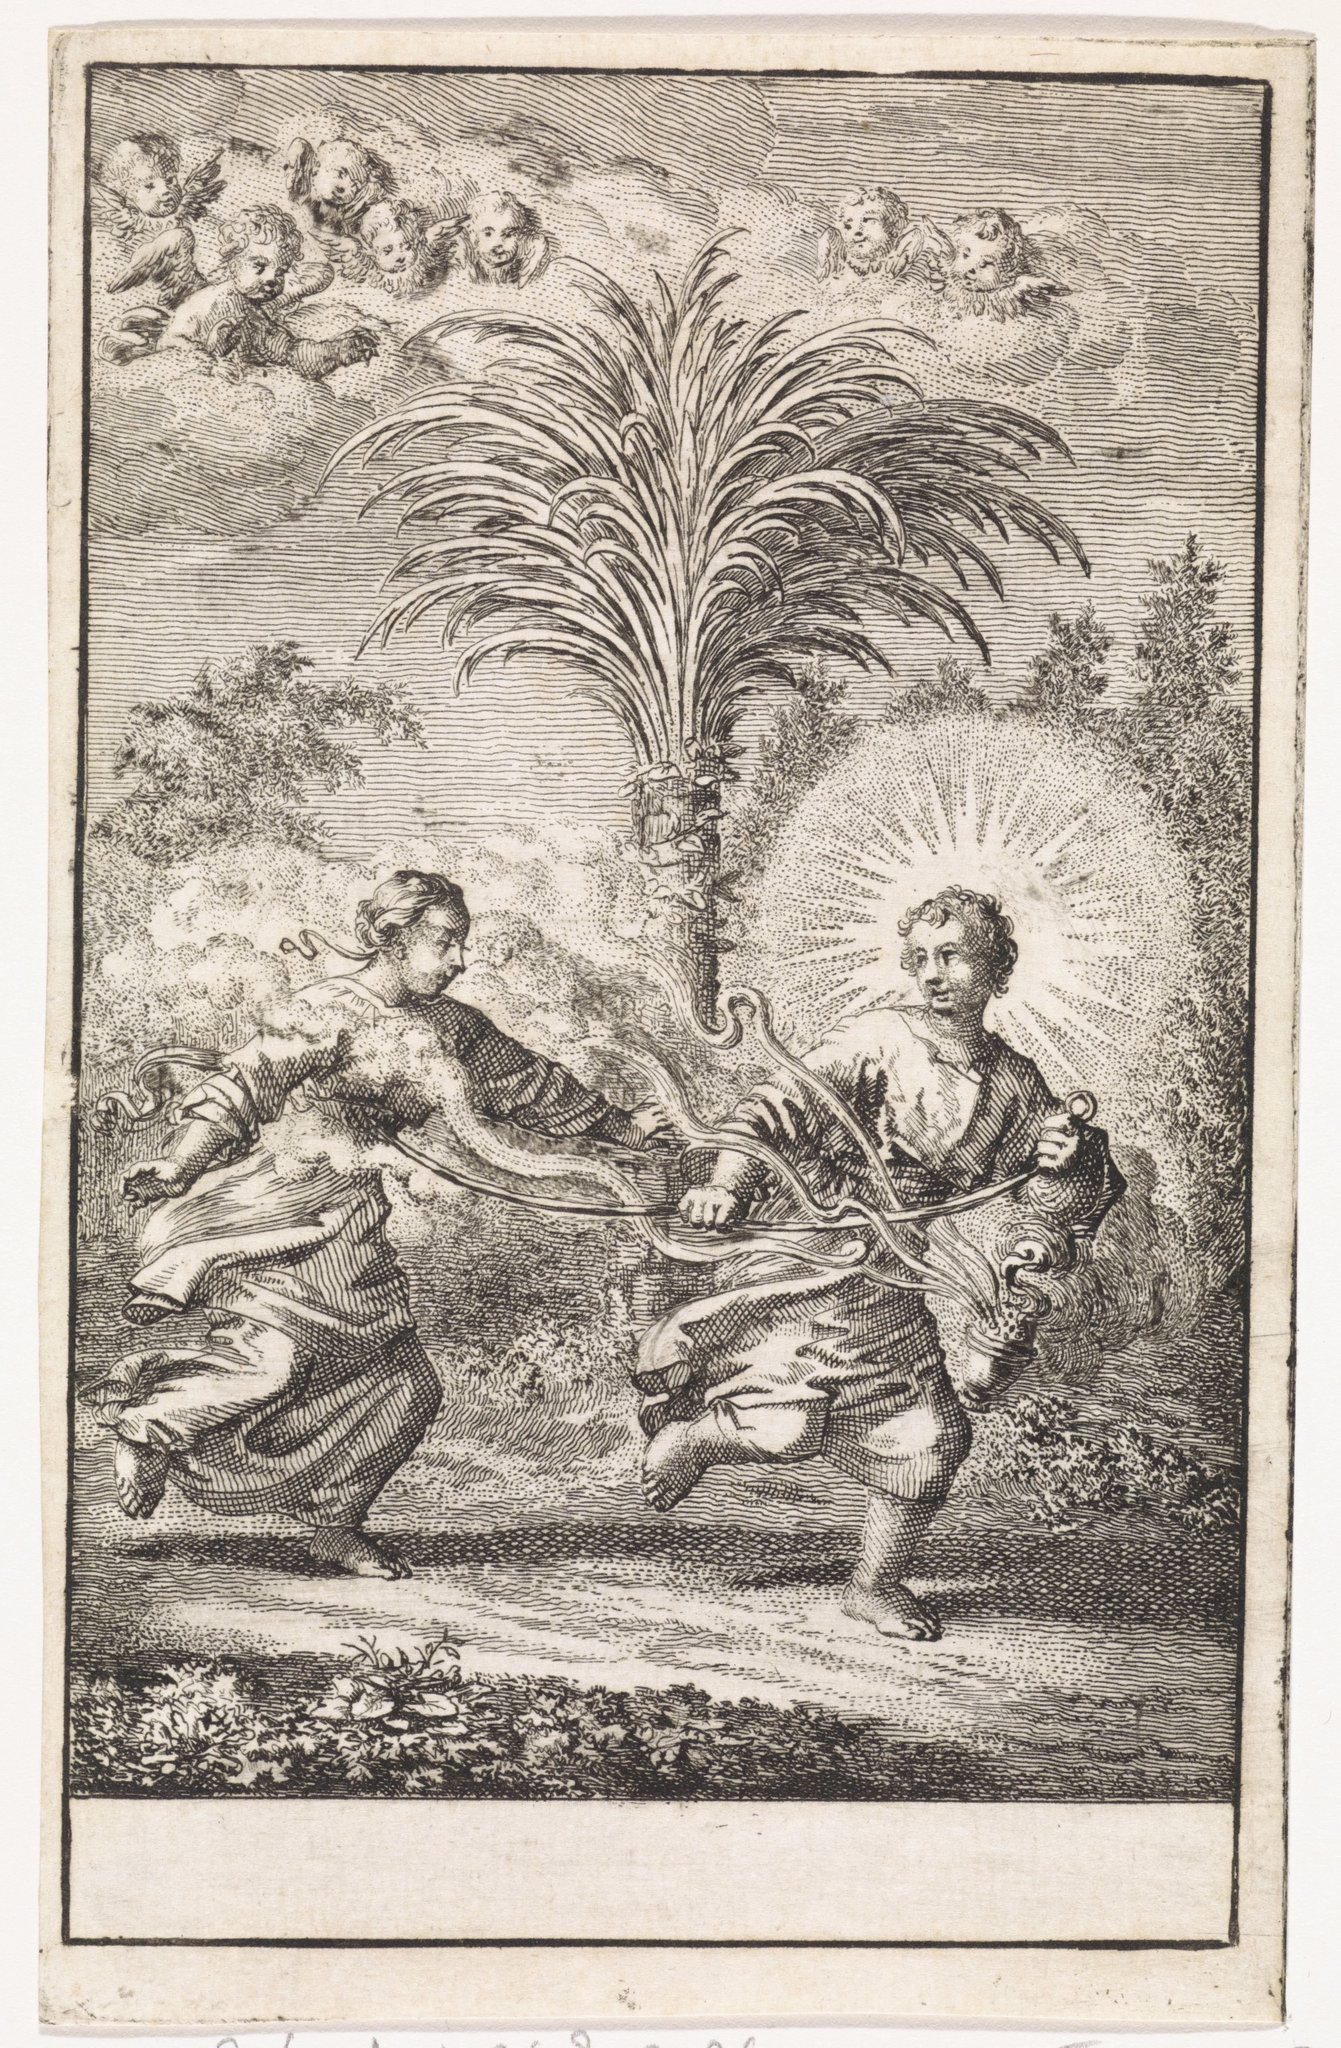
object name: print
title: Christus trekt de gepersonifieerde ziel rennend voort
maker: jan luyken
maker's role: draughtsman, print maker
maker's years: 1649-1712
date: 1714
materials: paper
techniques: etching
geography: amsterdam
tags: christ as youth, the soul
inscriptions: collector's mark: Lugt 2228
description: Proefdruk van titelpagina voor: Luyken, Jan. Jezus en de Ziel, 3 delen. Amsterdam: Wed. Pieter Arentsz II en Cornelis van der Sys, 1714.